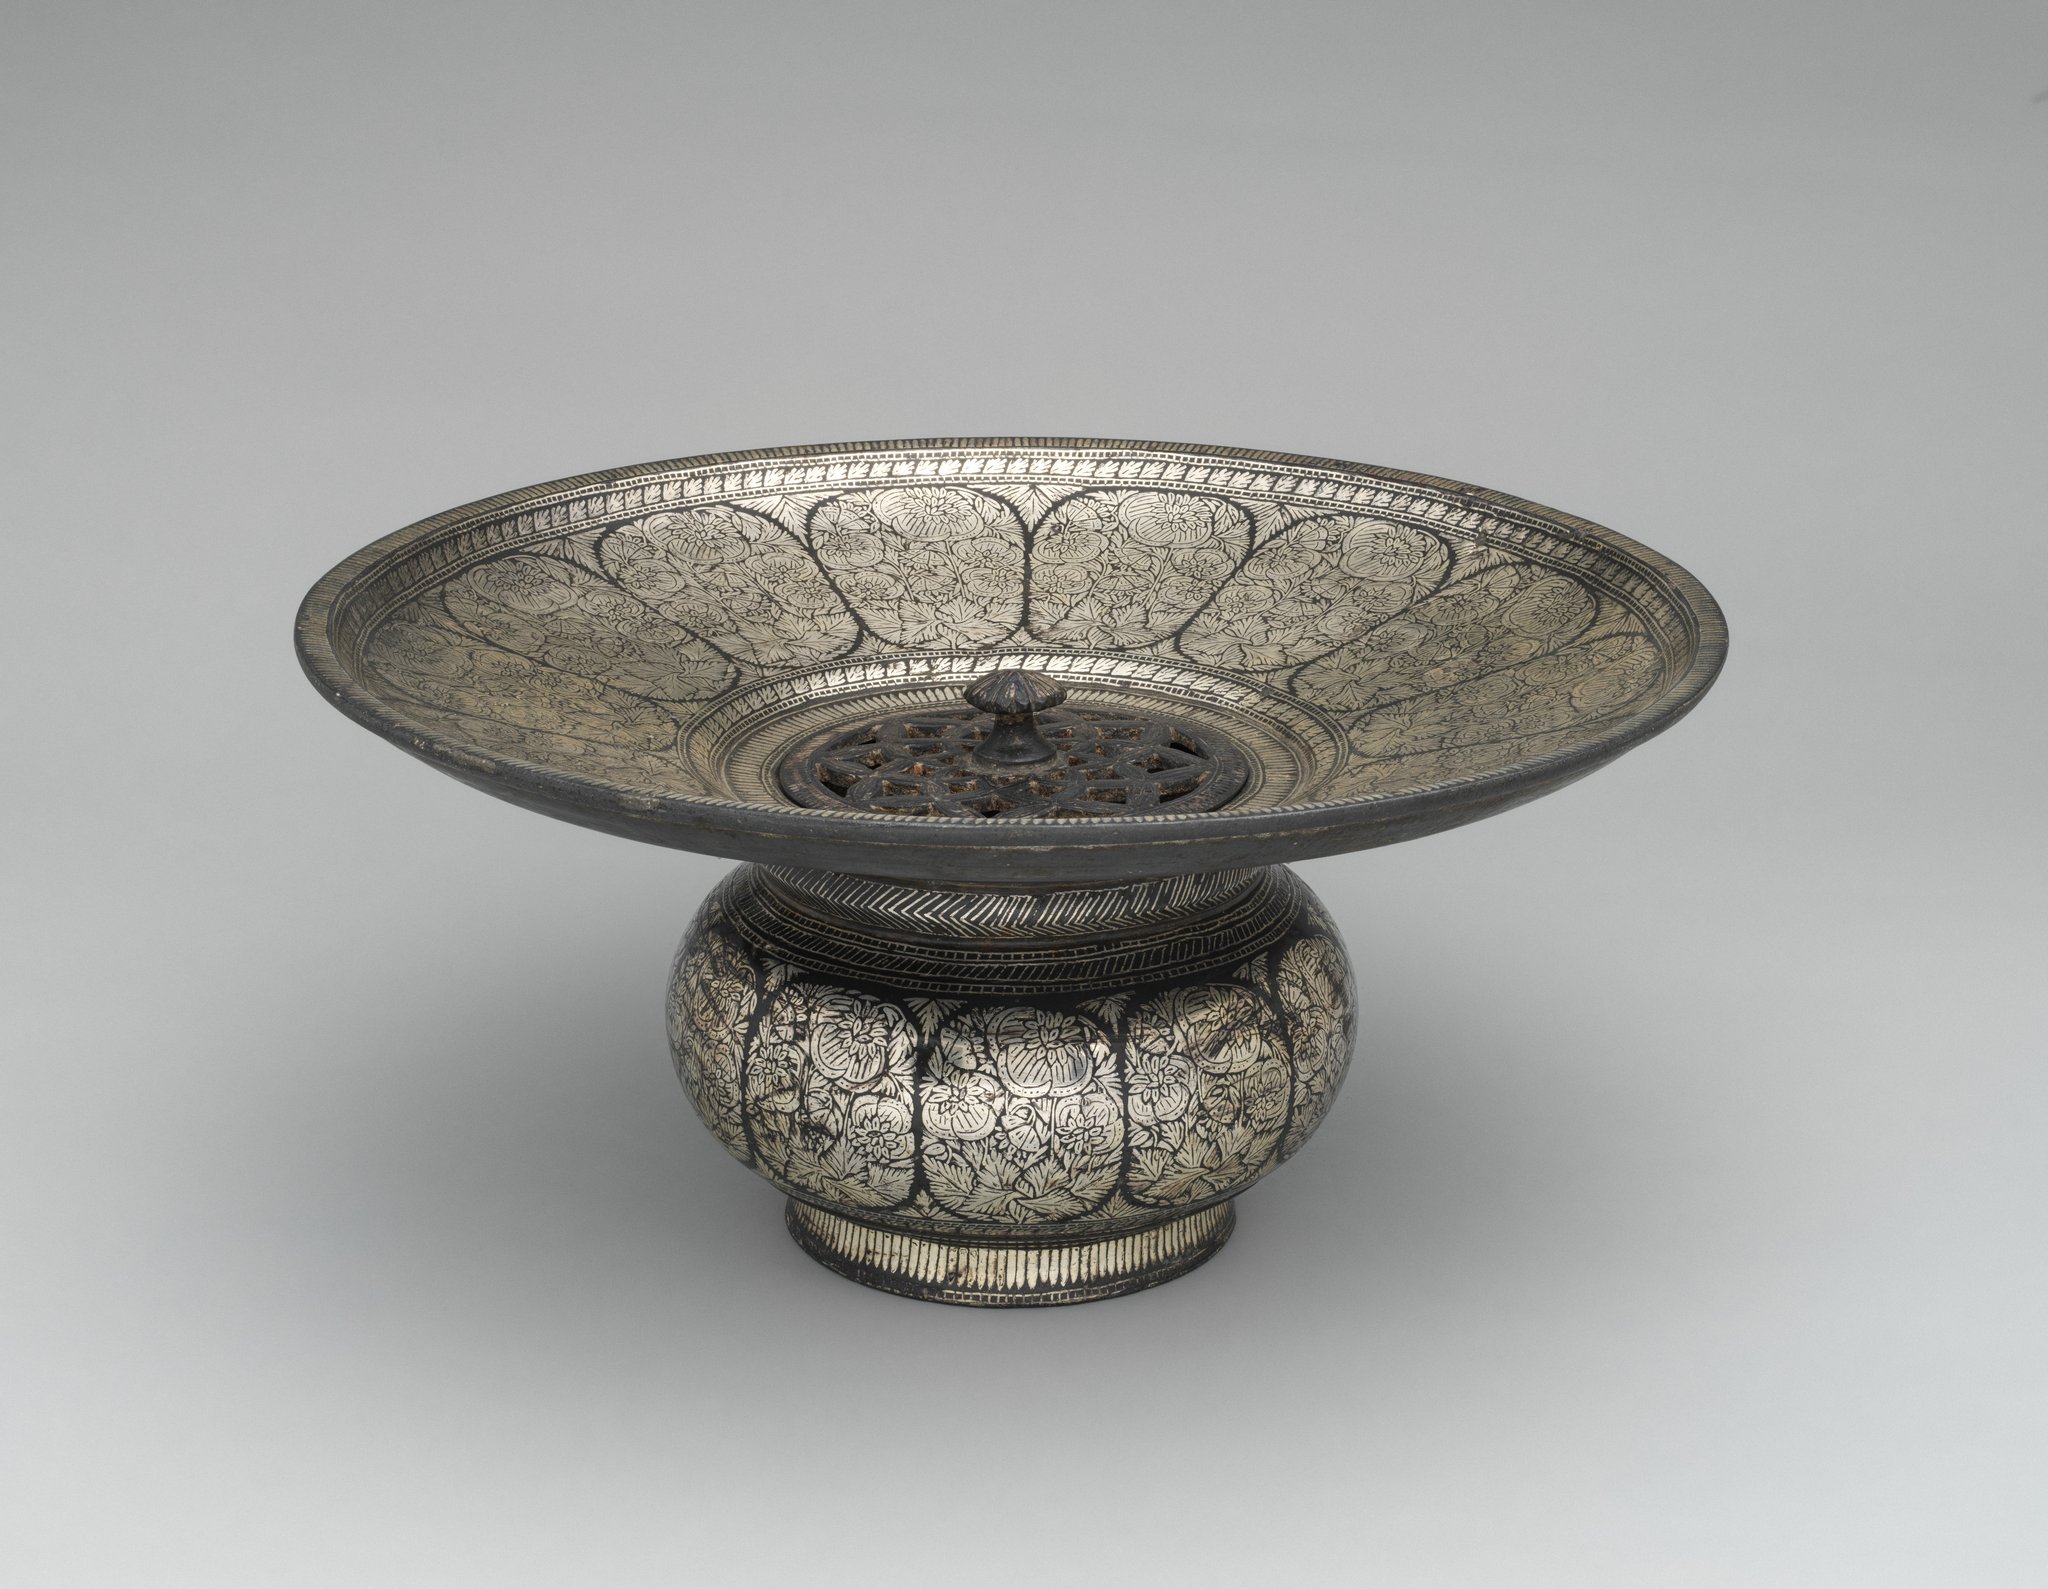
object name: basin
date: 1801-1900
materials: alloy, silver, zinc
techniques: casting, engraving, inlay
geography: india